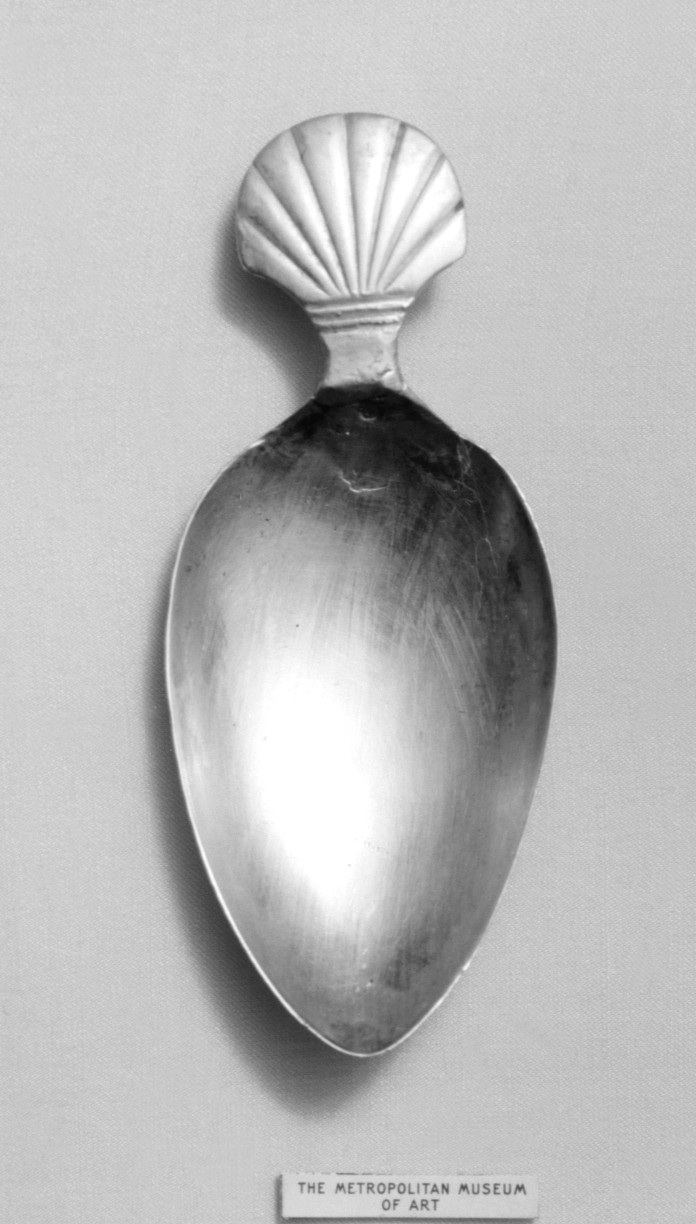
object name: caddy spoon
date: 1801-1900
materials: gilt, silver